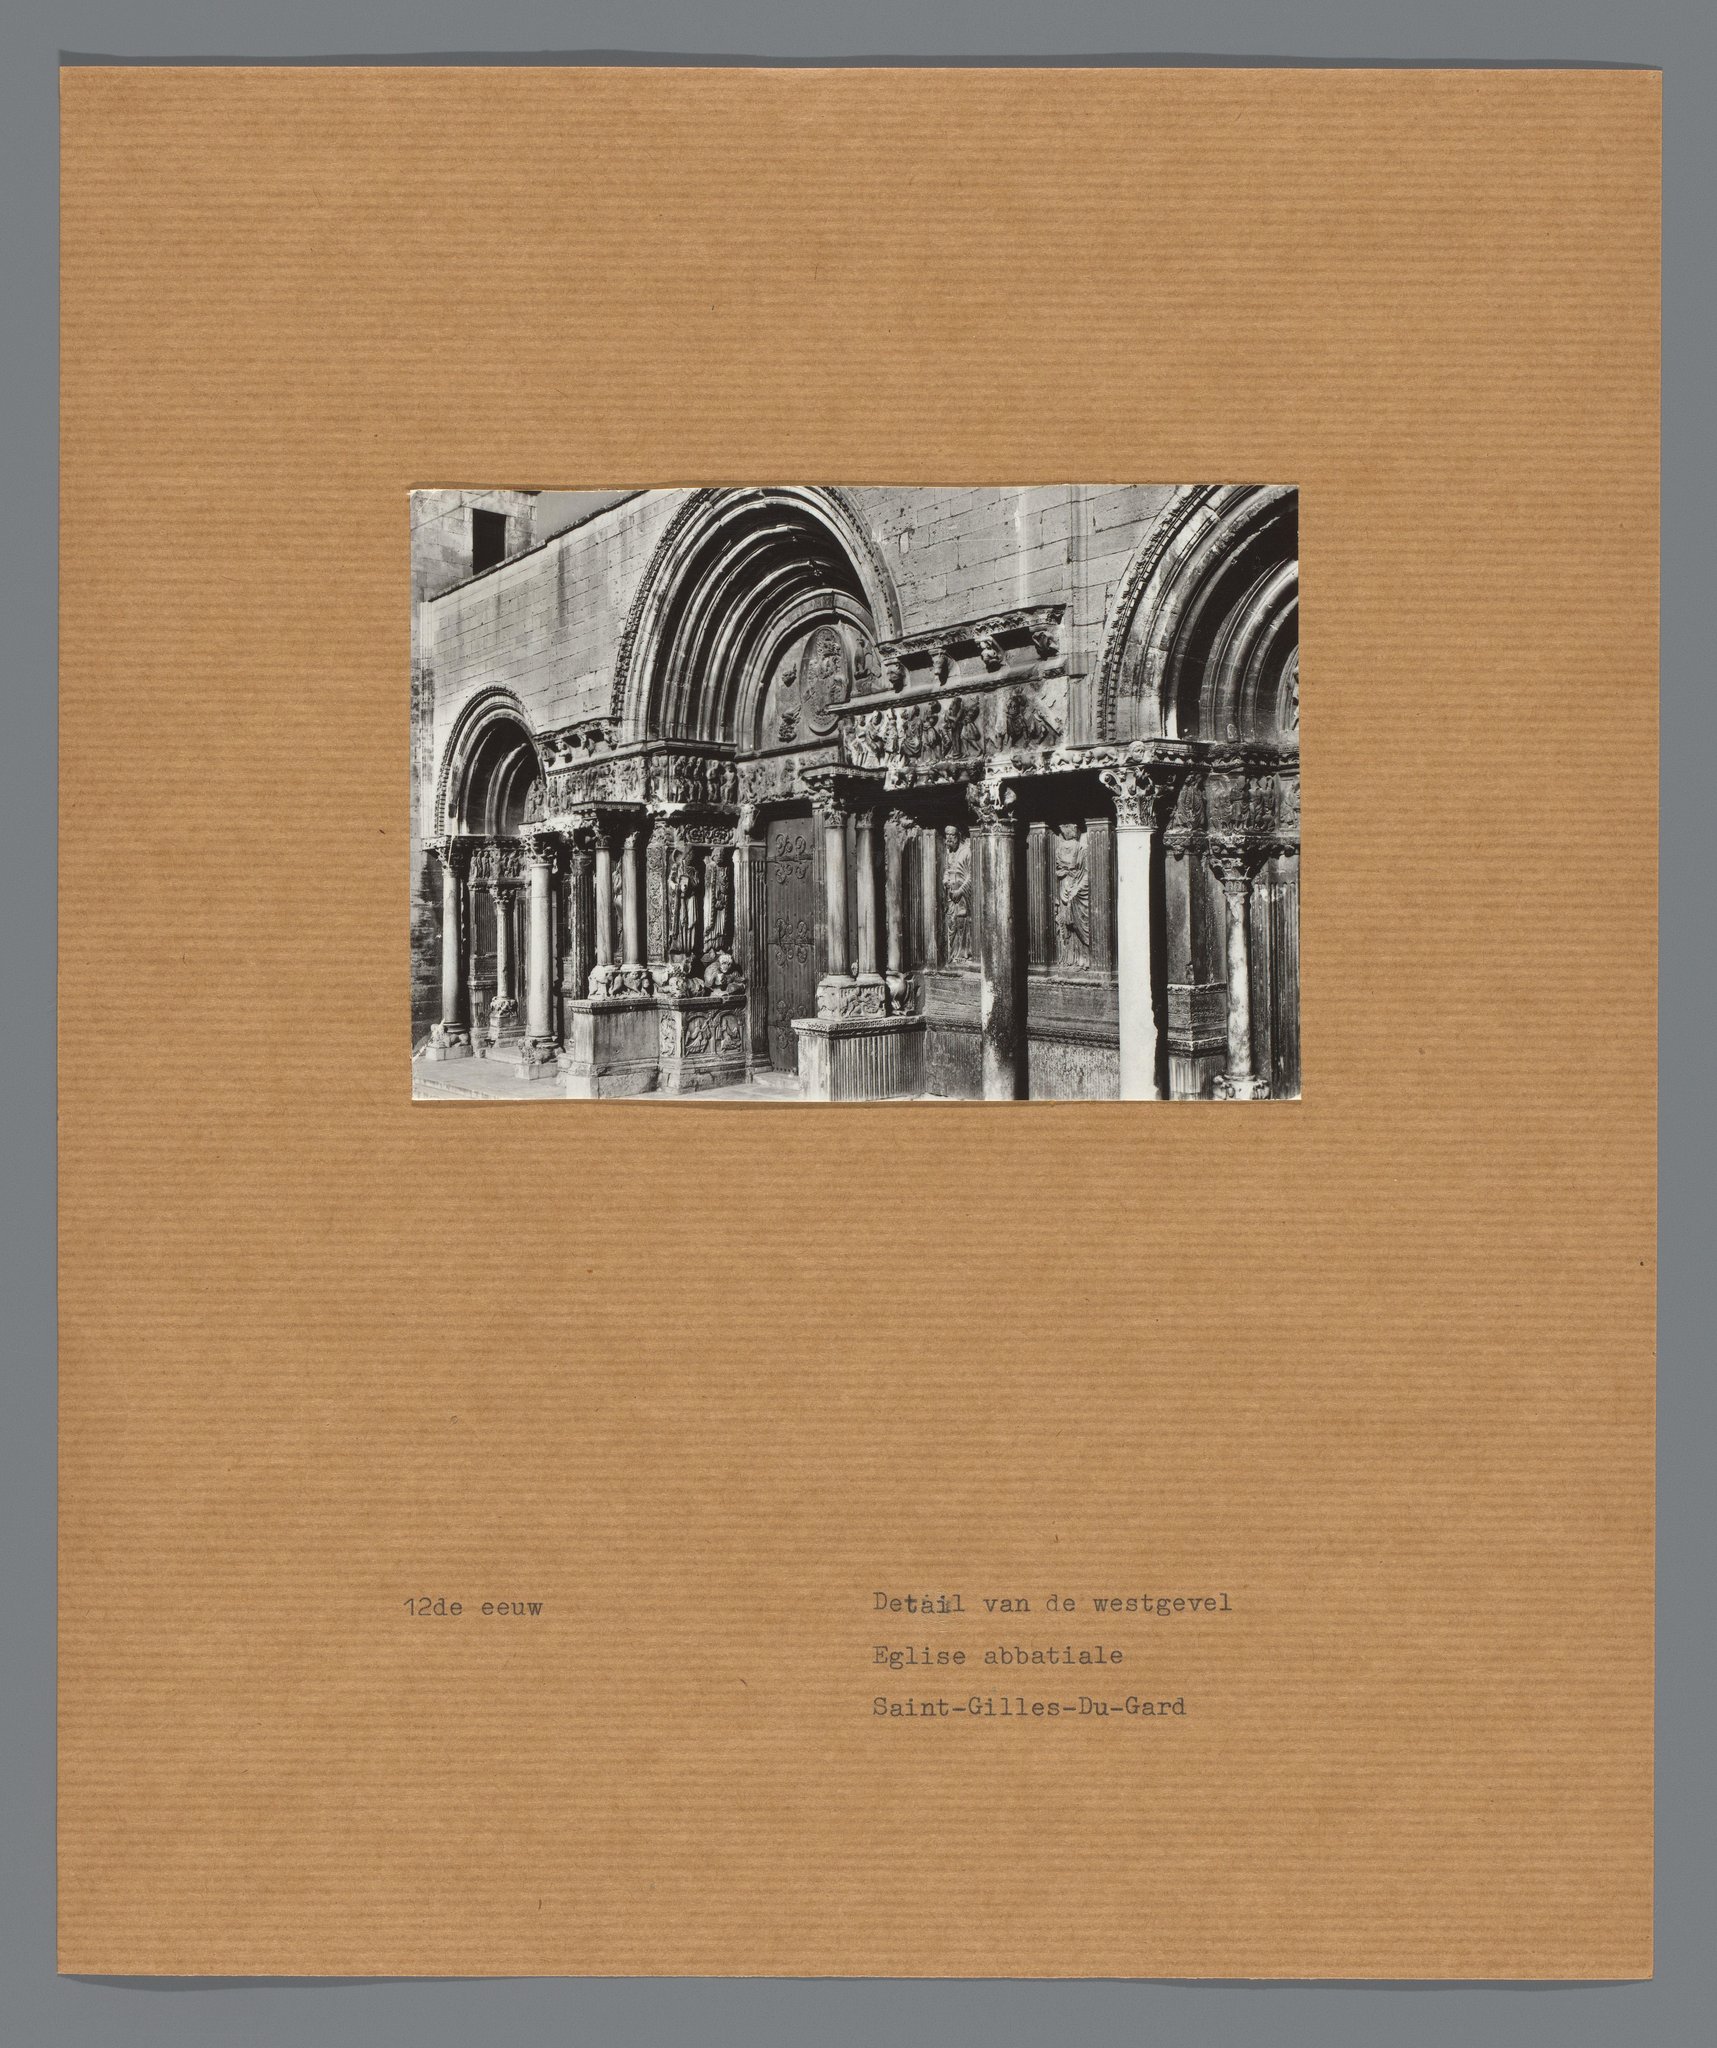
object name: photograph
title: Saint-Gilles, Kirche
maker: Anonymous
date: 1880-1930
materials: photographic support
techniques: gelatin silver print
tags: france